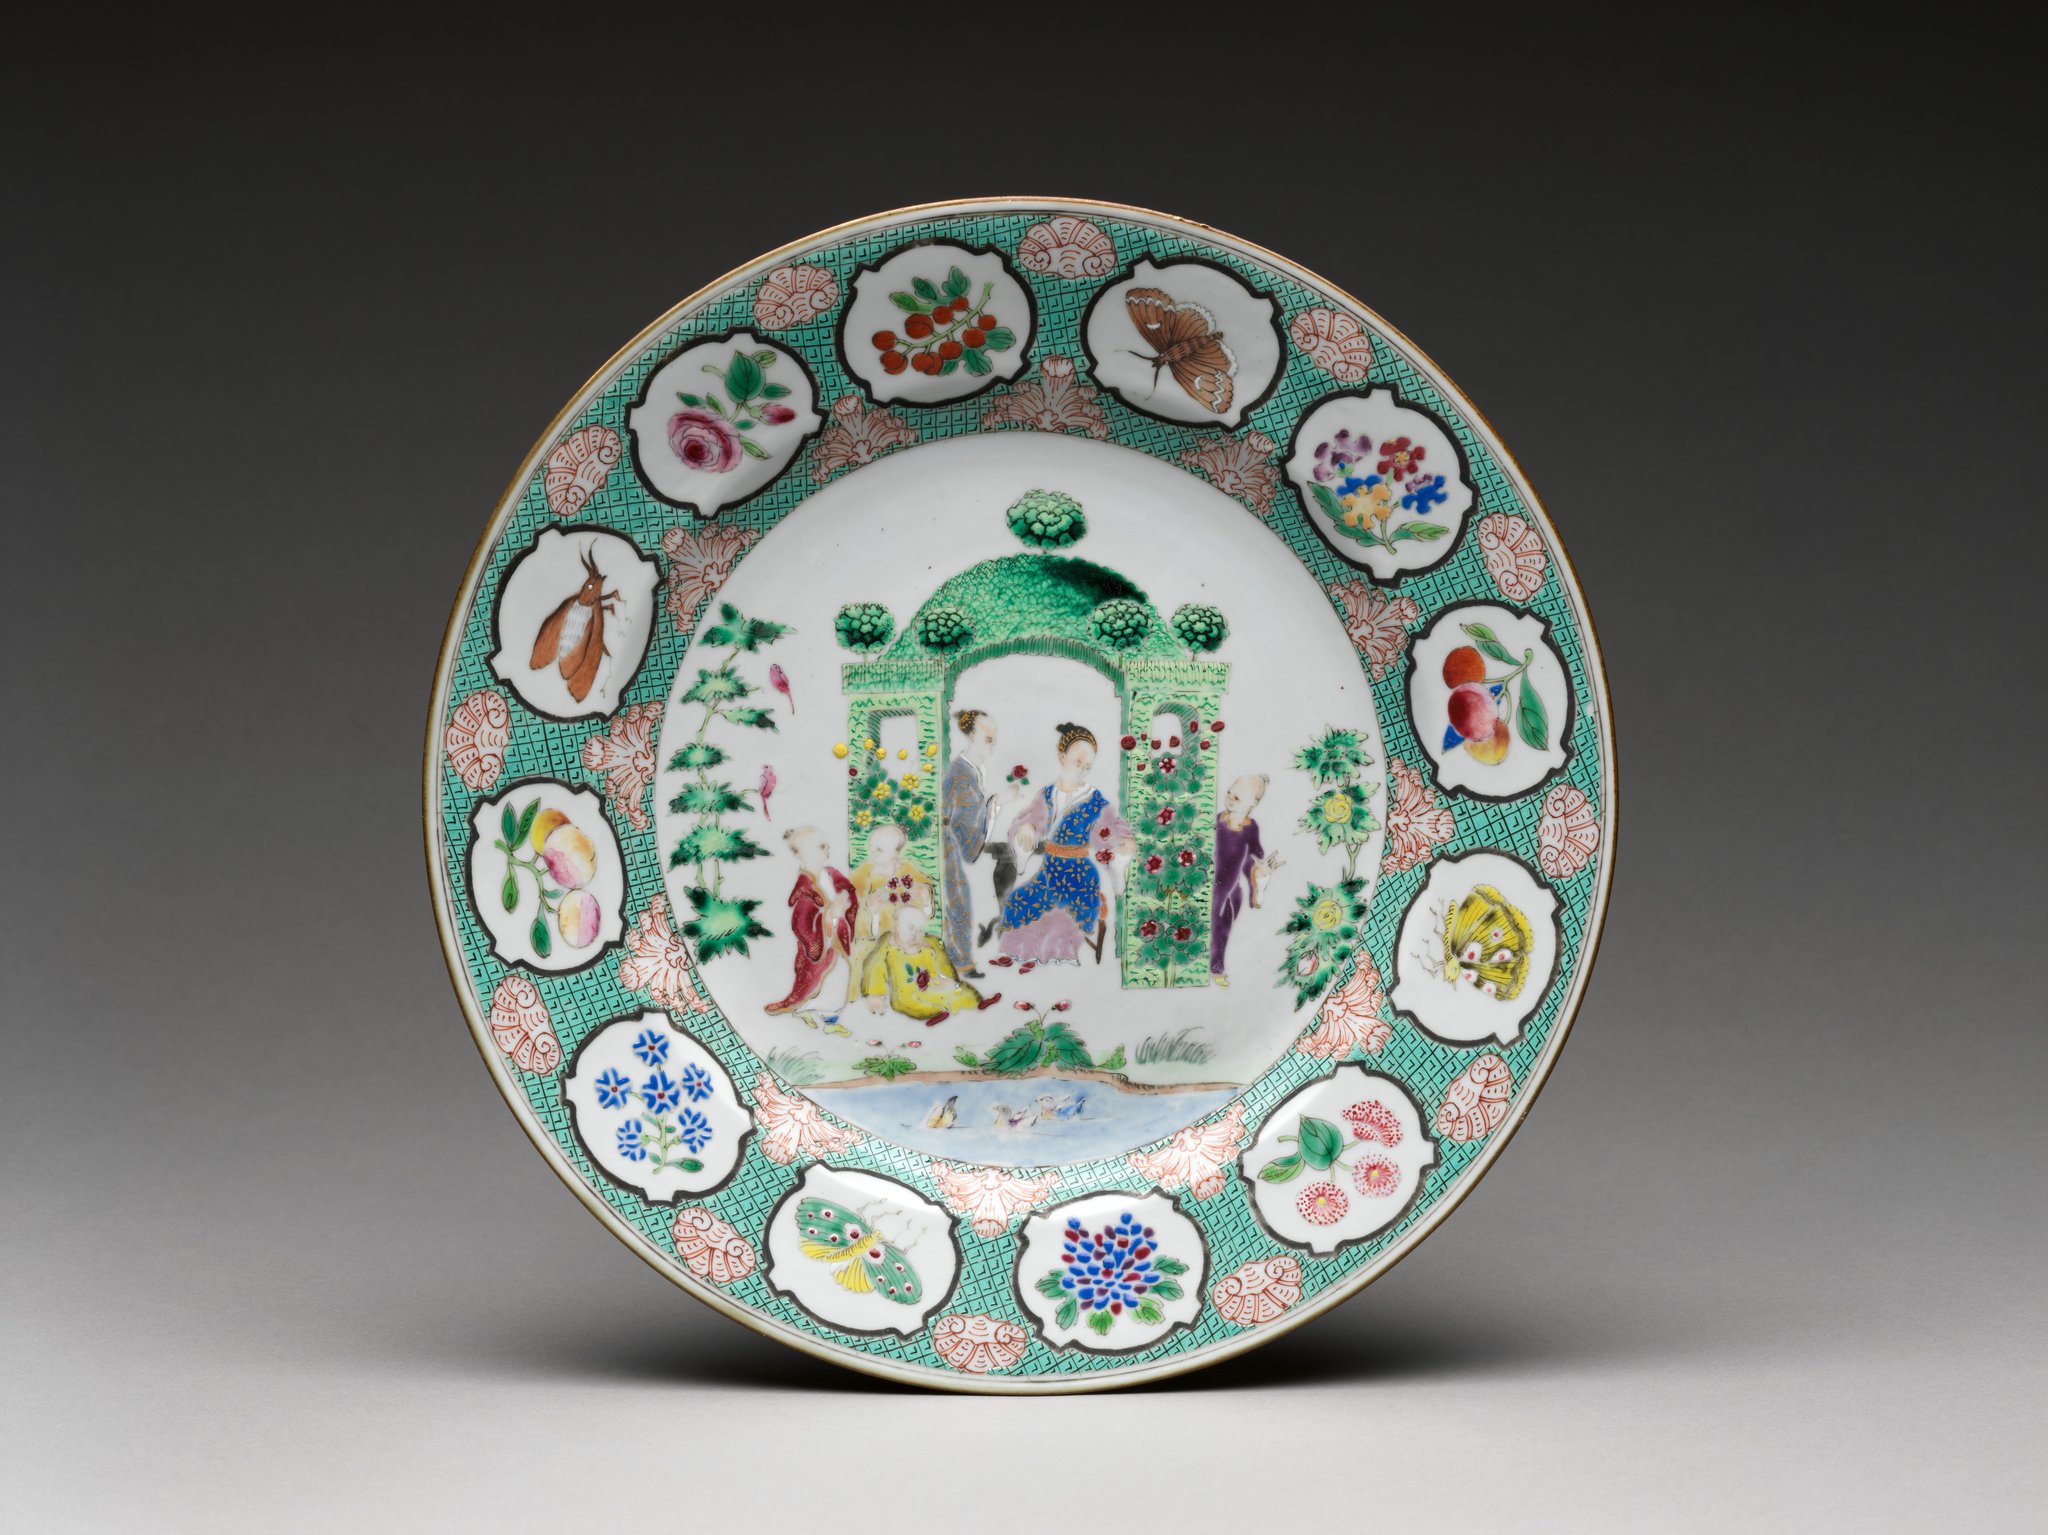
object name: plate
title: Plate with figures in arbor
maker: cornelis pronk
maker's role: artist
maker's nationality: dutch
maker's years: 1691-1759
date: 1740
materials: enamel, glaze, hard paste porcelain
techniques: painting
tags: human figures,butterflies,flowers